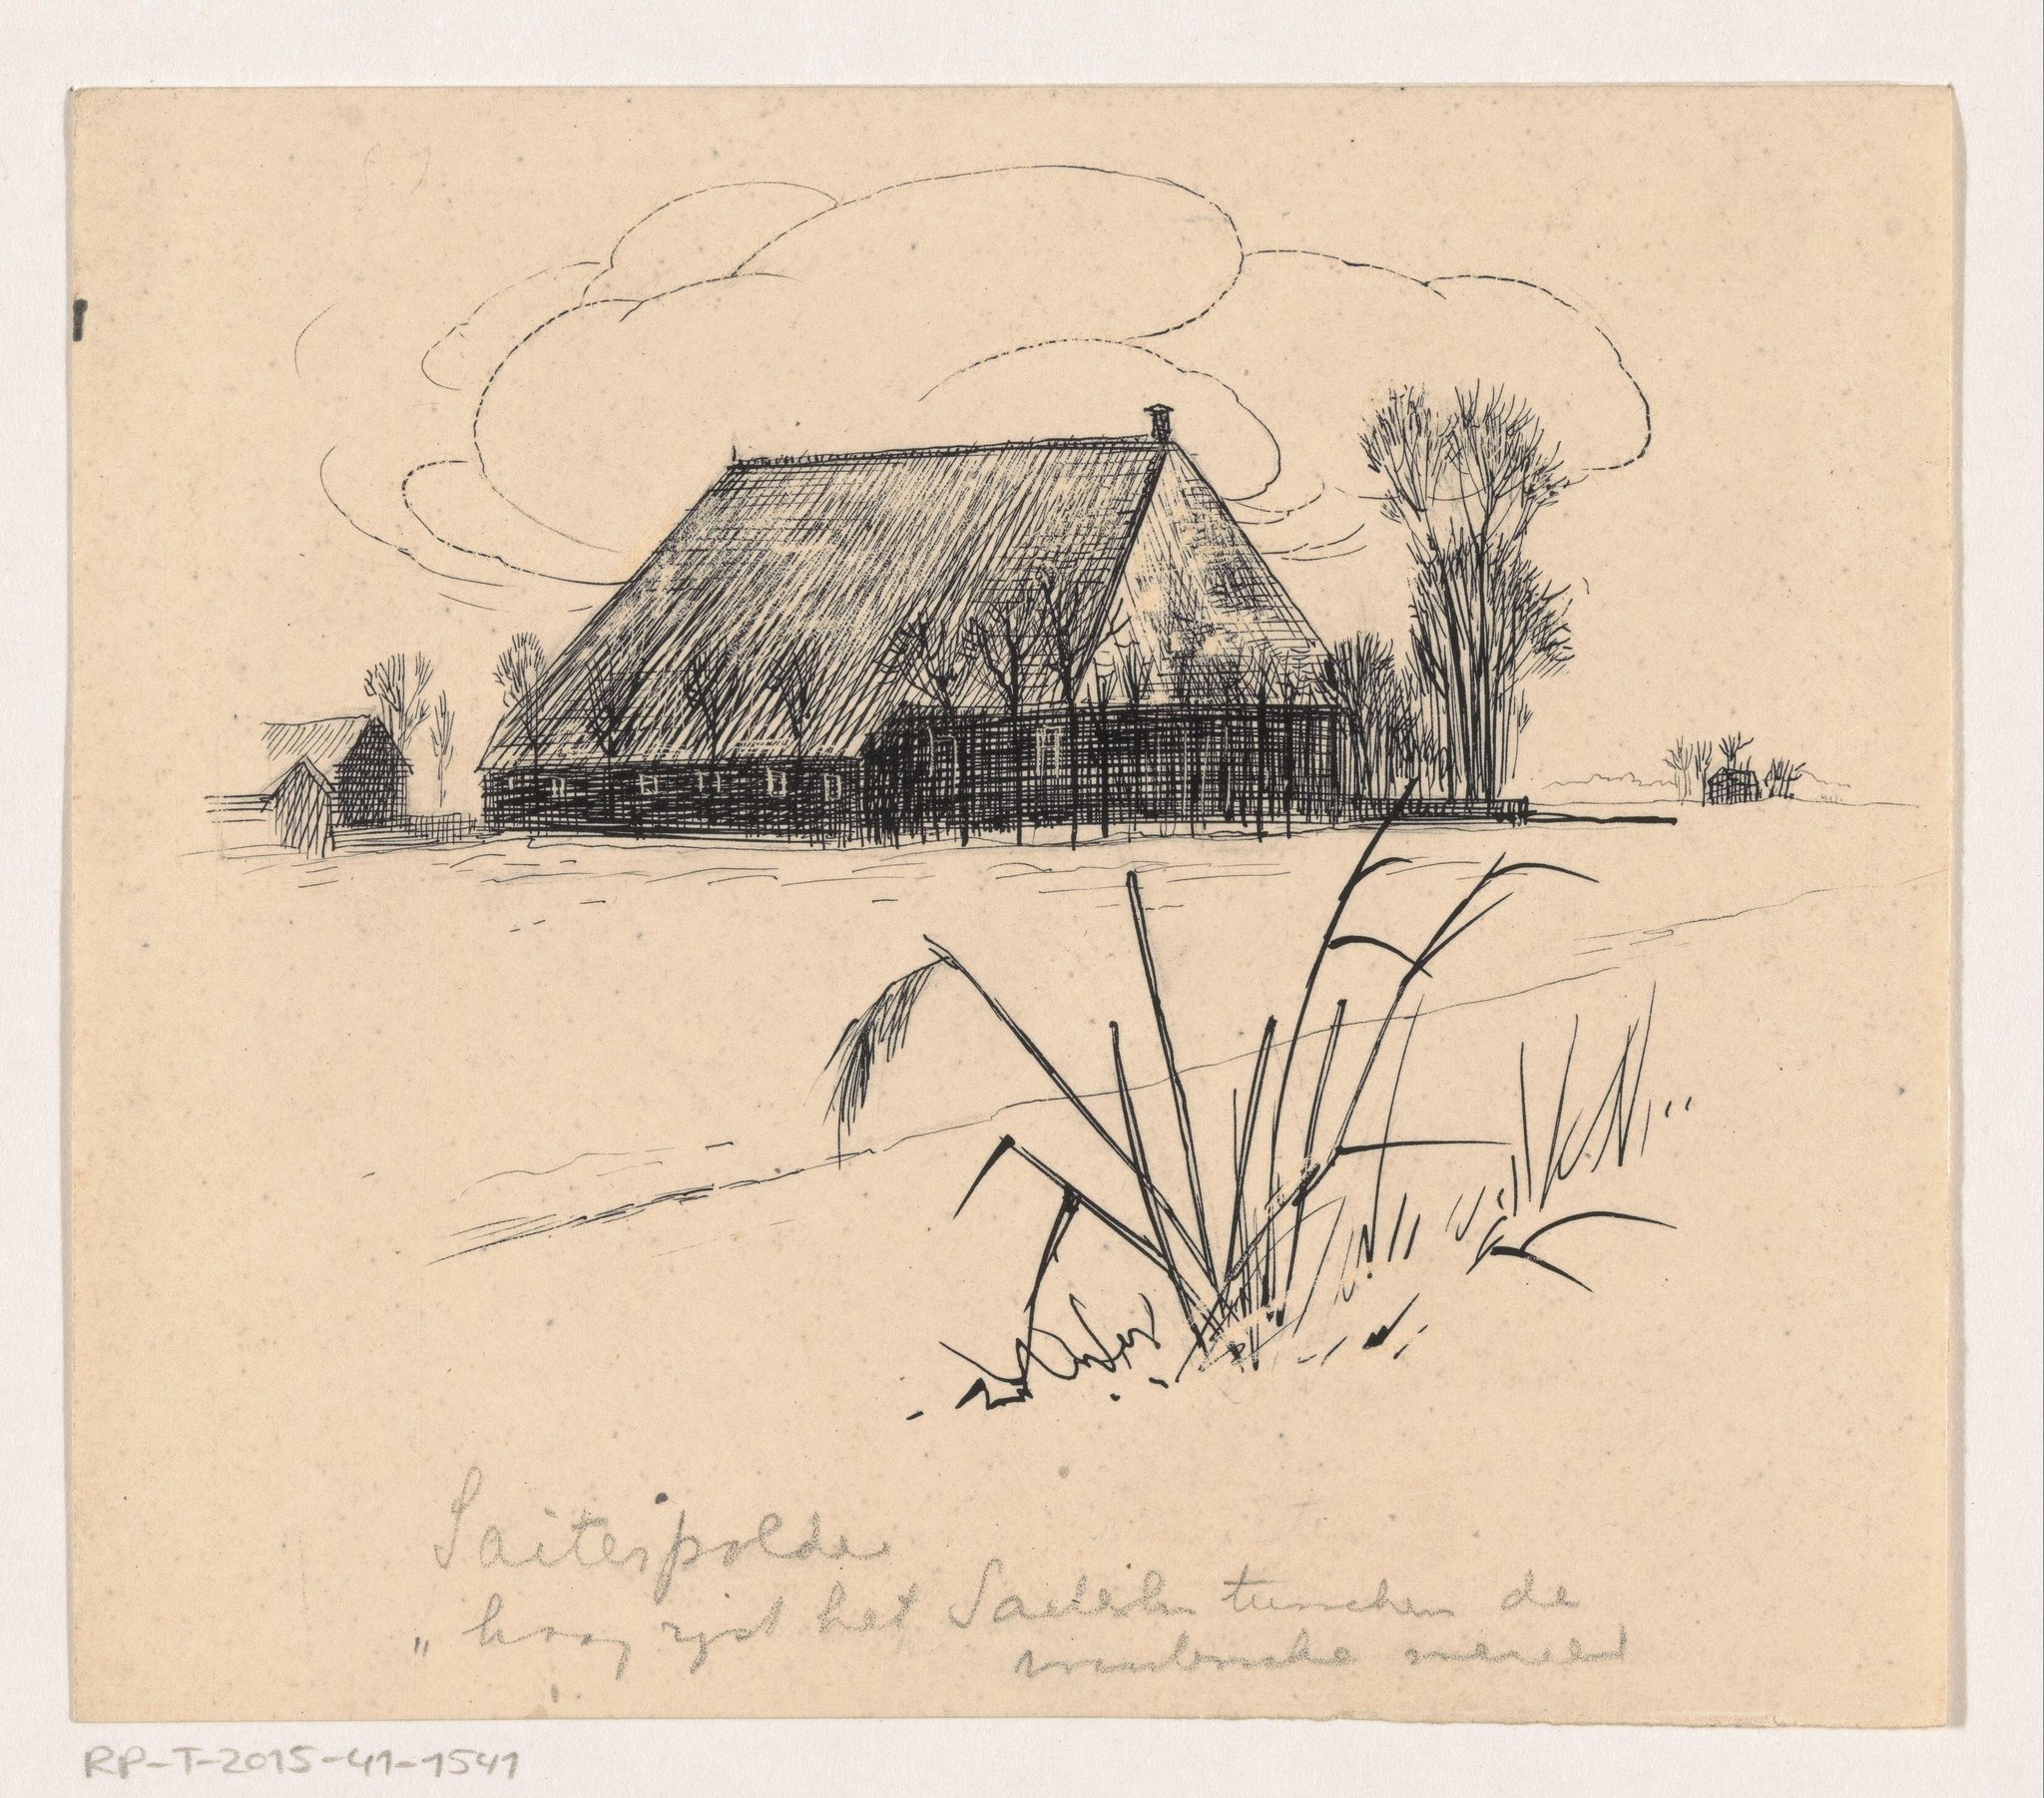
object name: boekillustratie ontwerp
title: Schuur in de Saiterpolder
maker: henri verstijnen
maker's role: draughtsman, print maker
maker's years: 1882-1940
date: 1892-1940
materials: ink, paper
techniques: pen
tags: barn, polder, reclaimed land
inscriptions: :, collector's mark: Lugt 2228, annotation: ‘Saiterpolder/ "hoog rijst het Sait[...] tusschen de/ [...]’